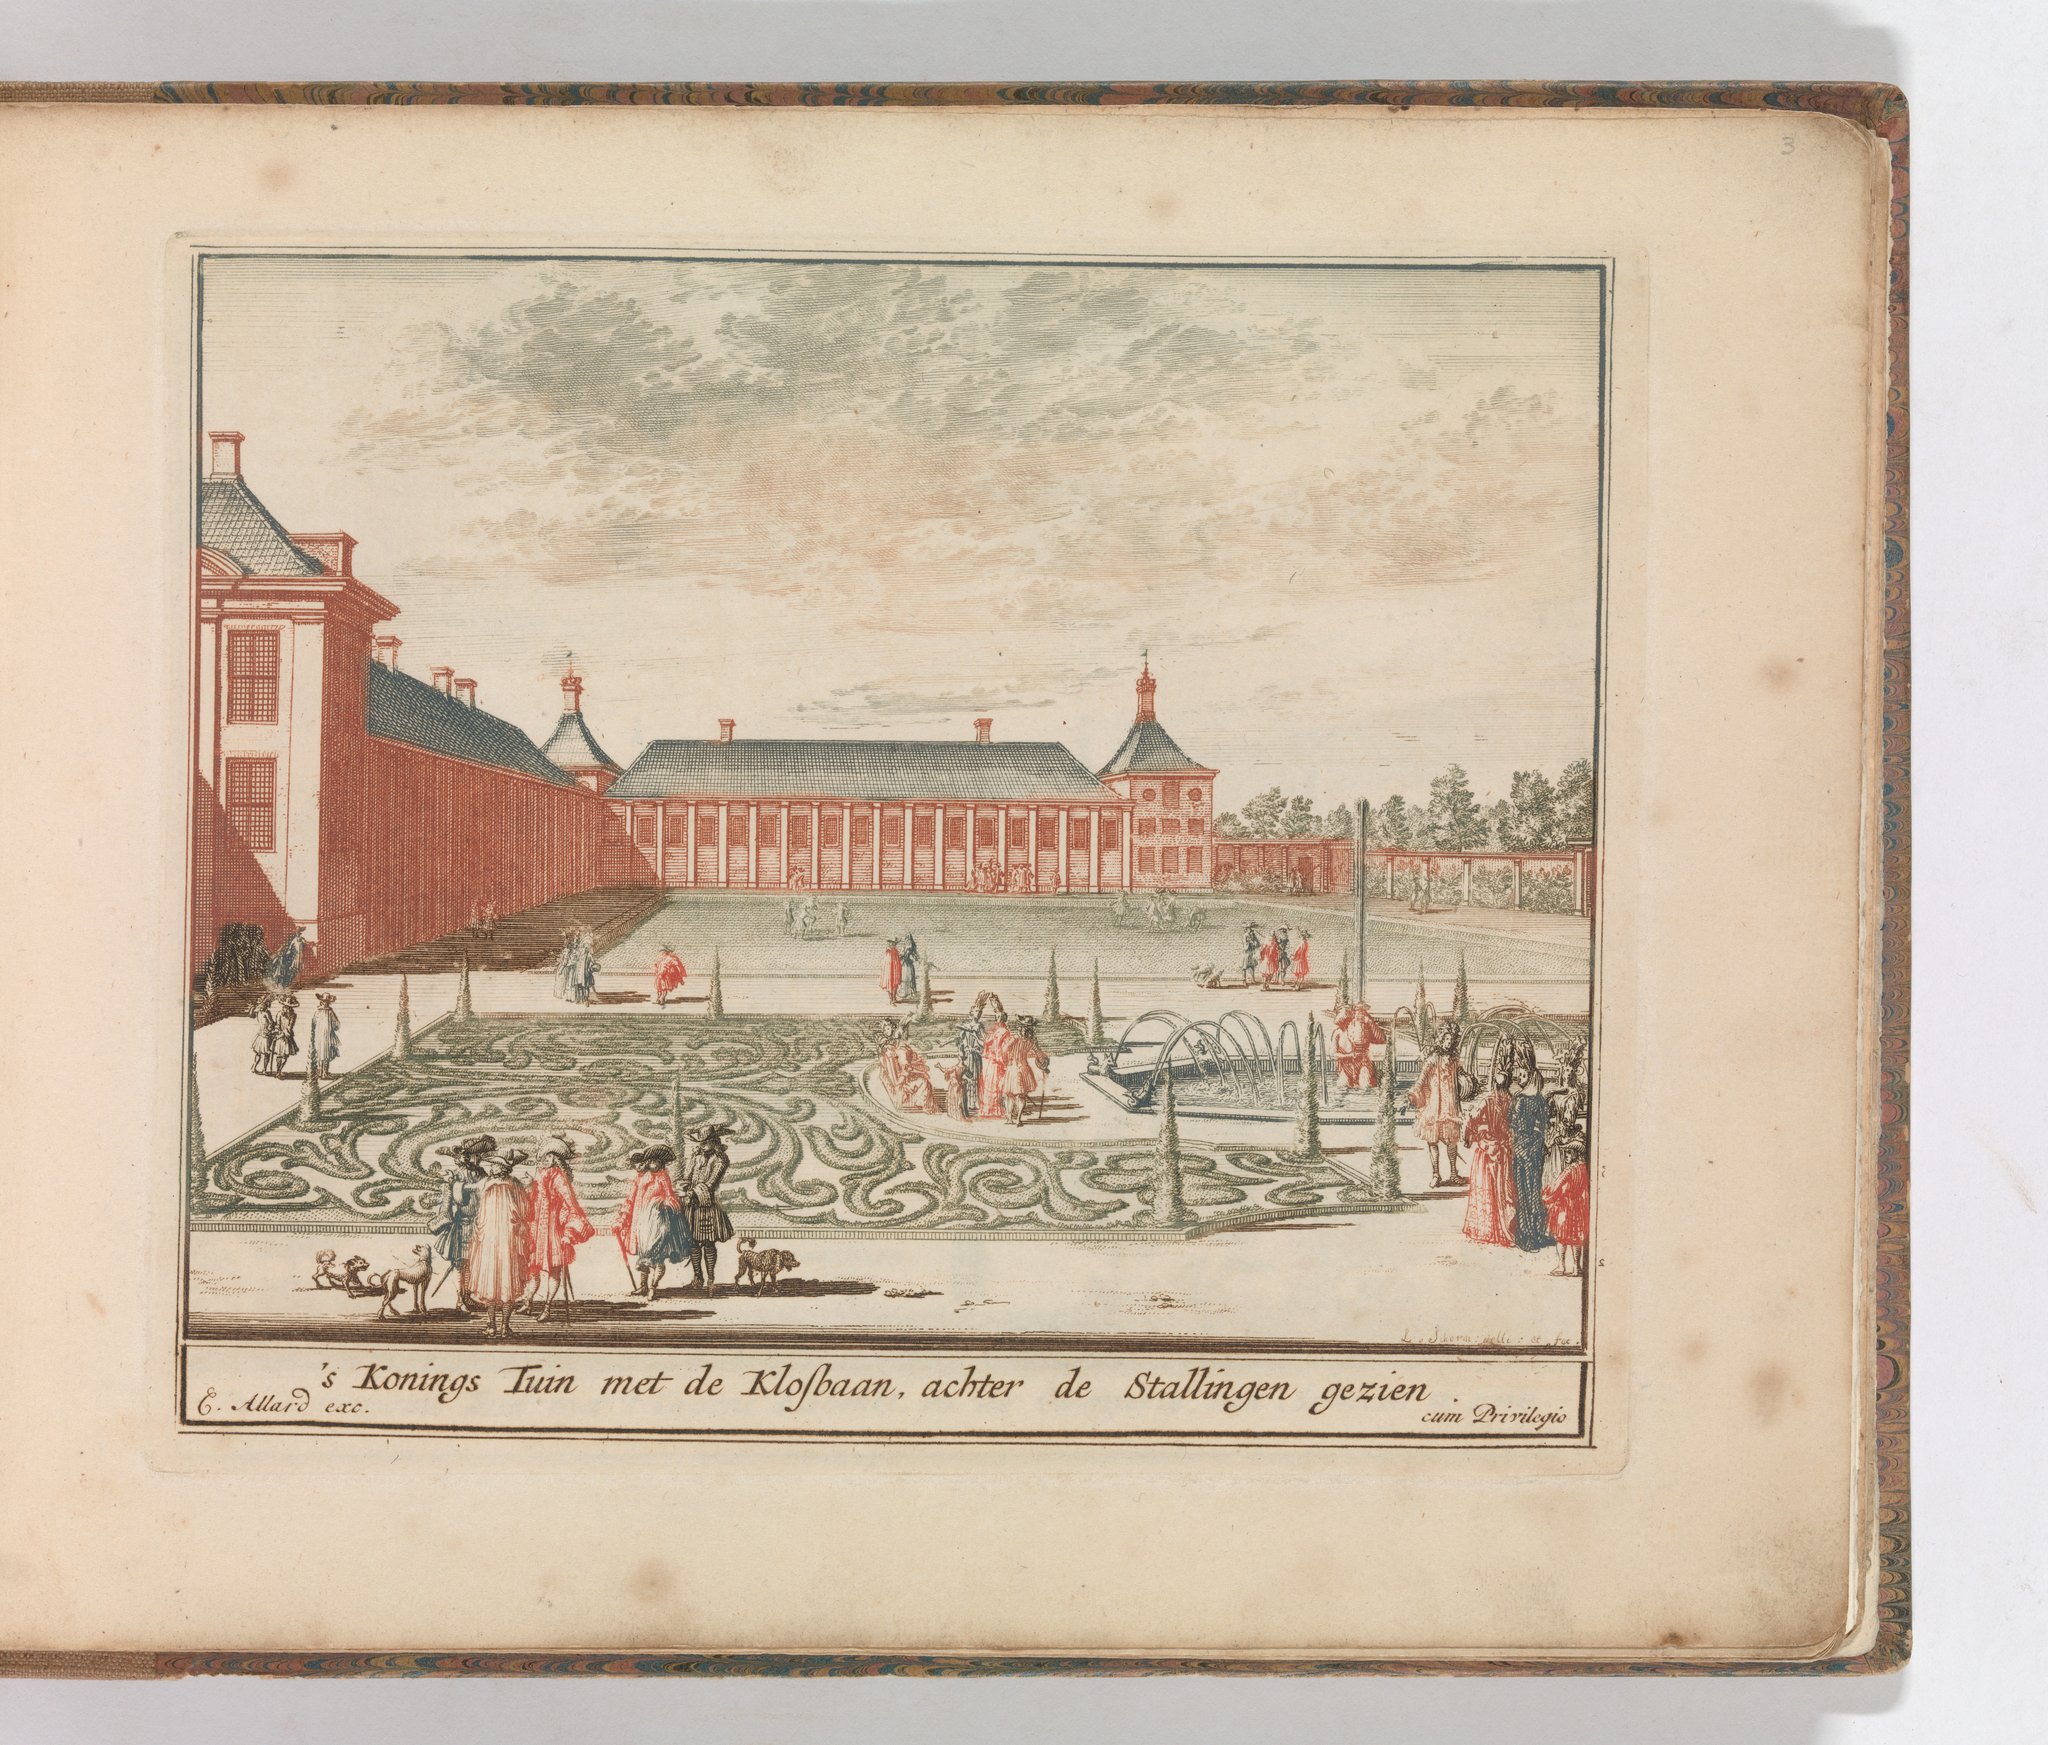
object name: book print ornament architecture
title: ' ’s Konings Tuin met de Klosbaan, achter de Stallingen gezien", in: Tooneel Der Voornaamste Nederlands Huizen, En Lust Hoven, Naar T Leven Afgebeeld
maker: carel allard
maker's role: publisher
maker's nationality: dutch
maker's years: 1648-1709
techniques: engraving, lithography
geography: amsterdam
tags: architecture,fountains,palaces,gardens,men,women,dogs,trees